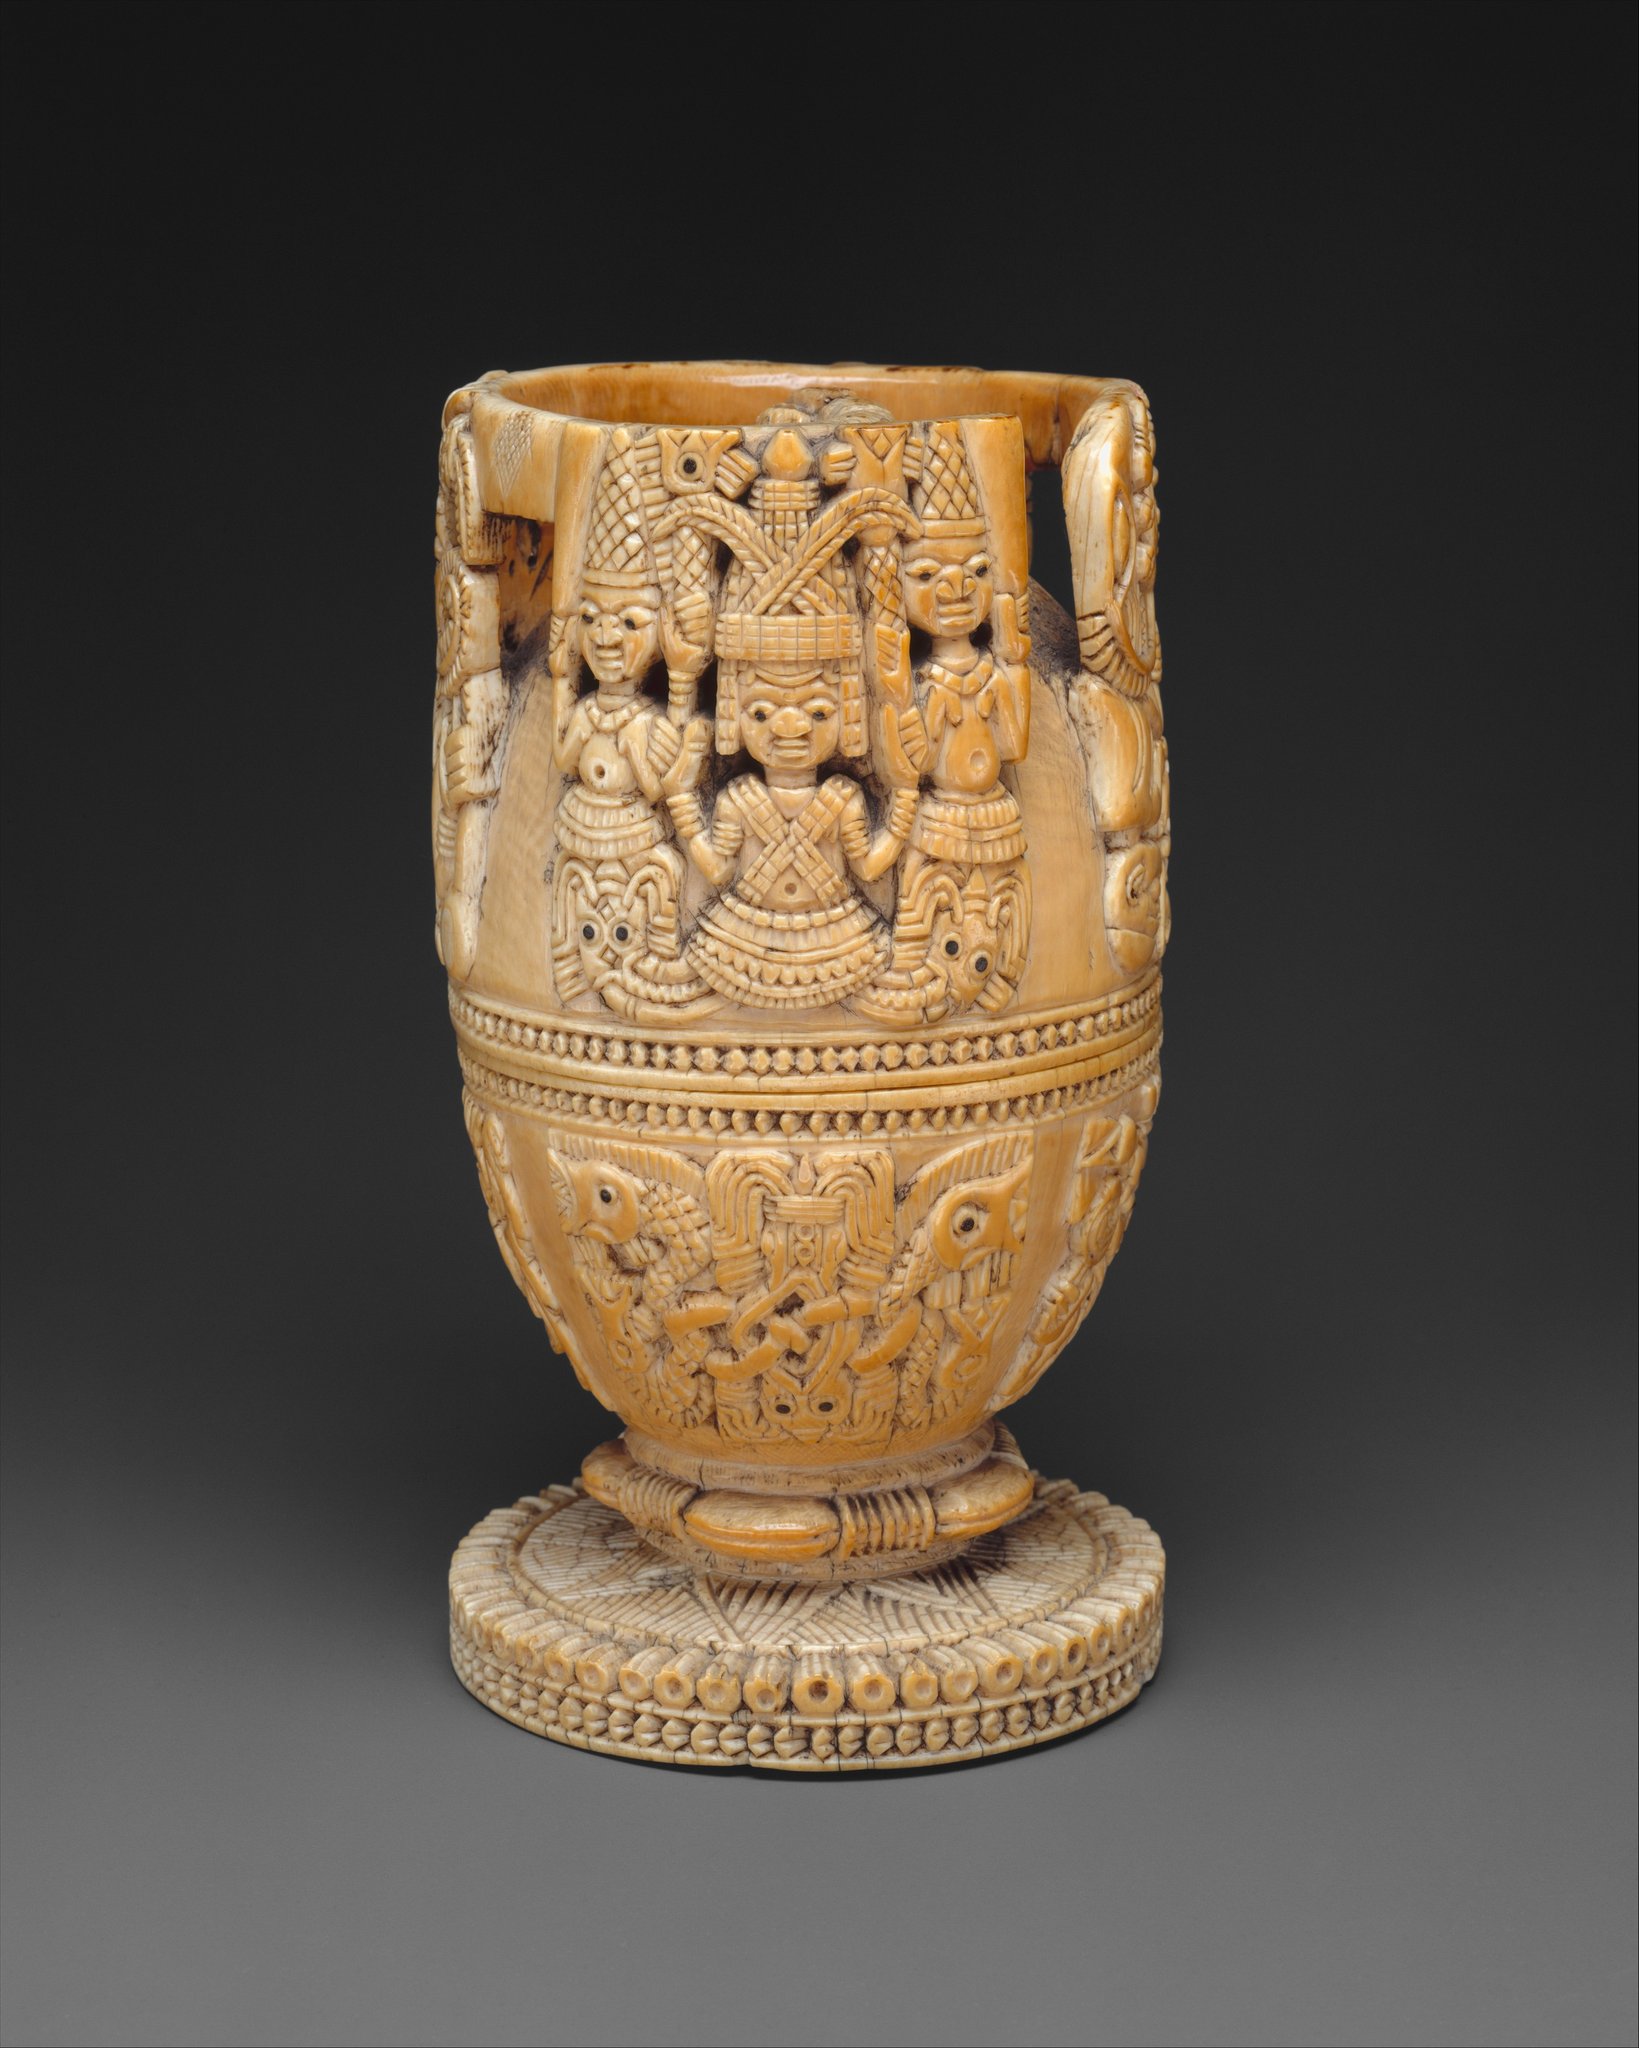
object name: vessel with lid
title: Lidded Vessel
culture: yoruba peoples, owo group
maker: yoruba artist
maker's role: artist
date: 1601-1800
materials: plant material, ivory, wood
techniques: inlay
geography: nigeria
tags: human figures,crocodiles,fish